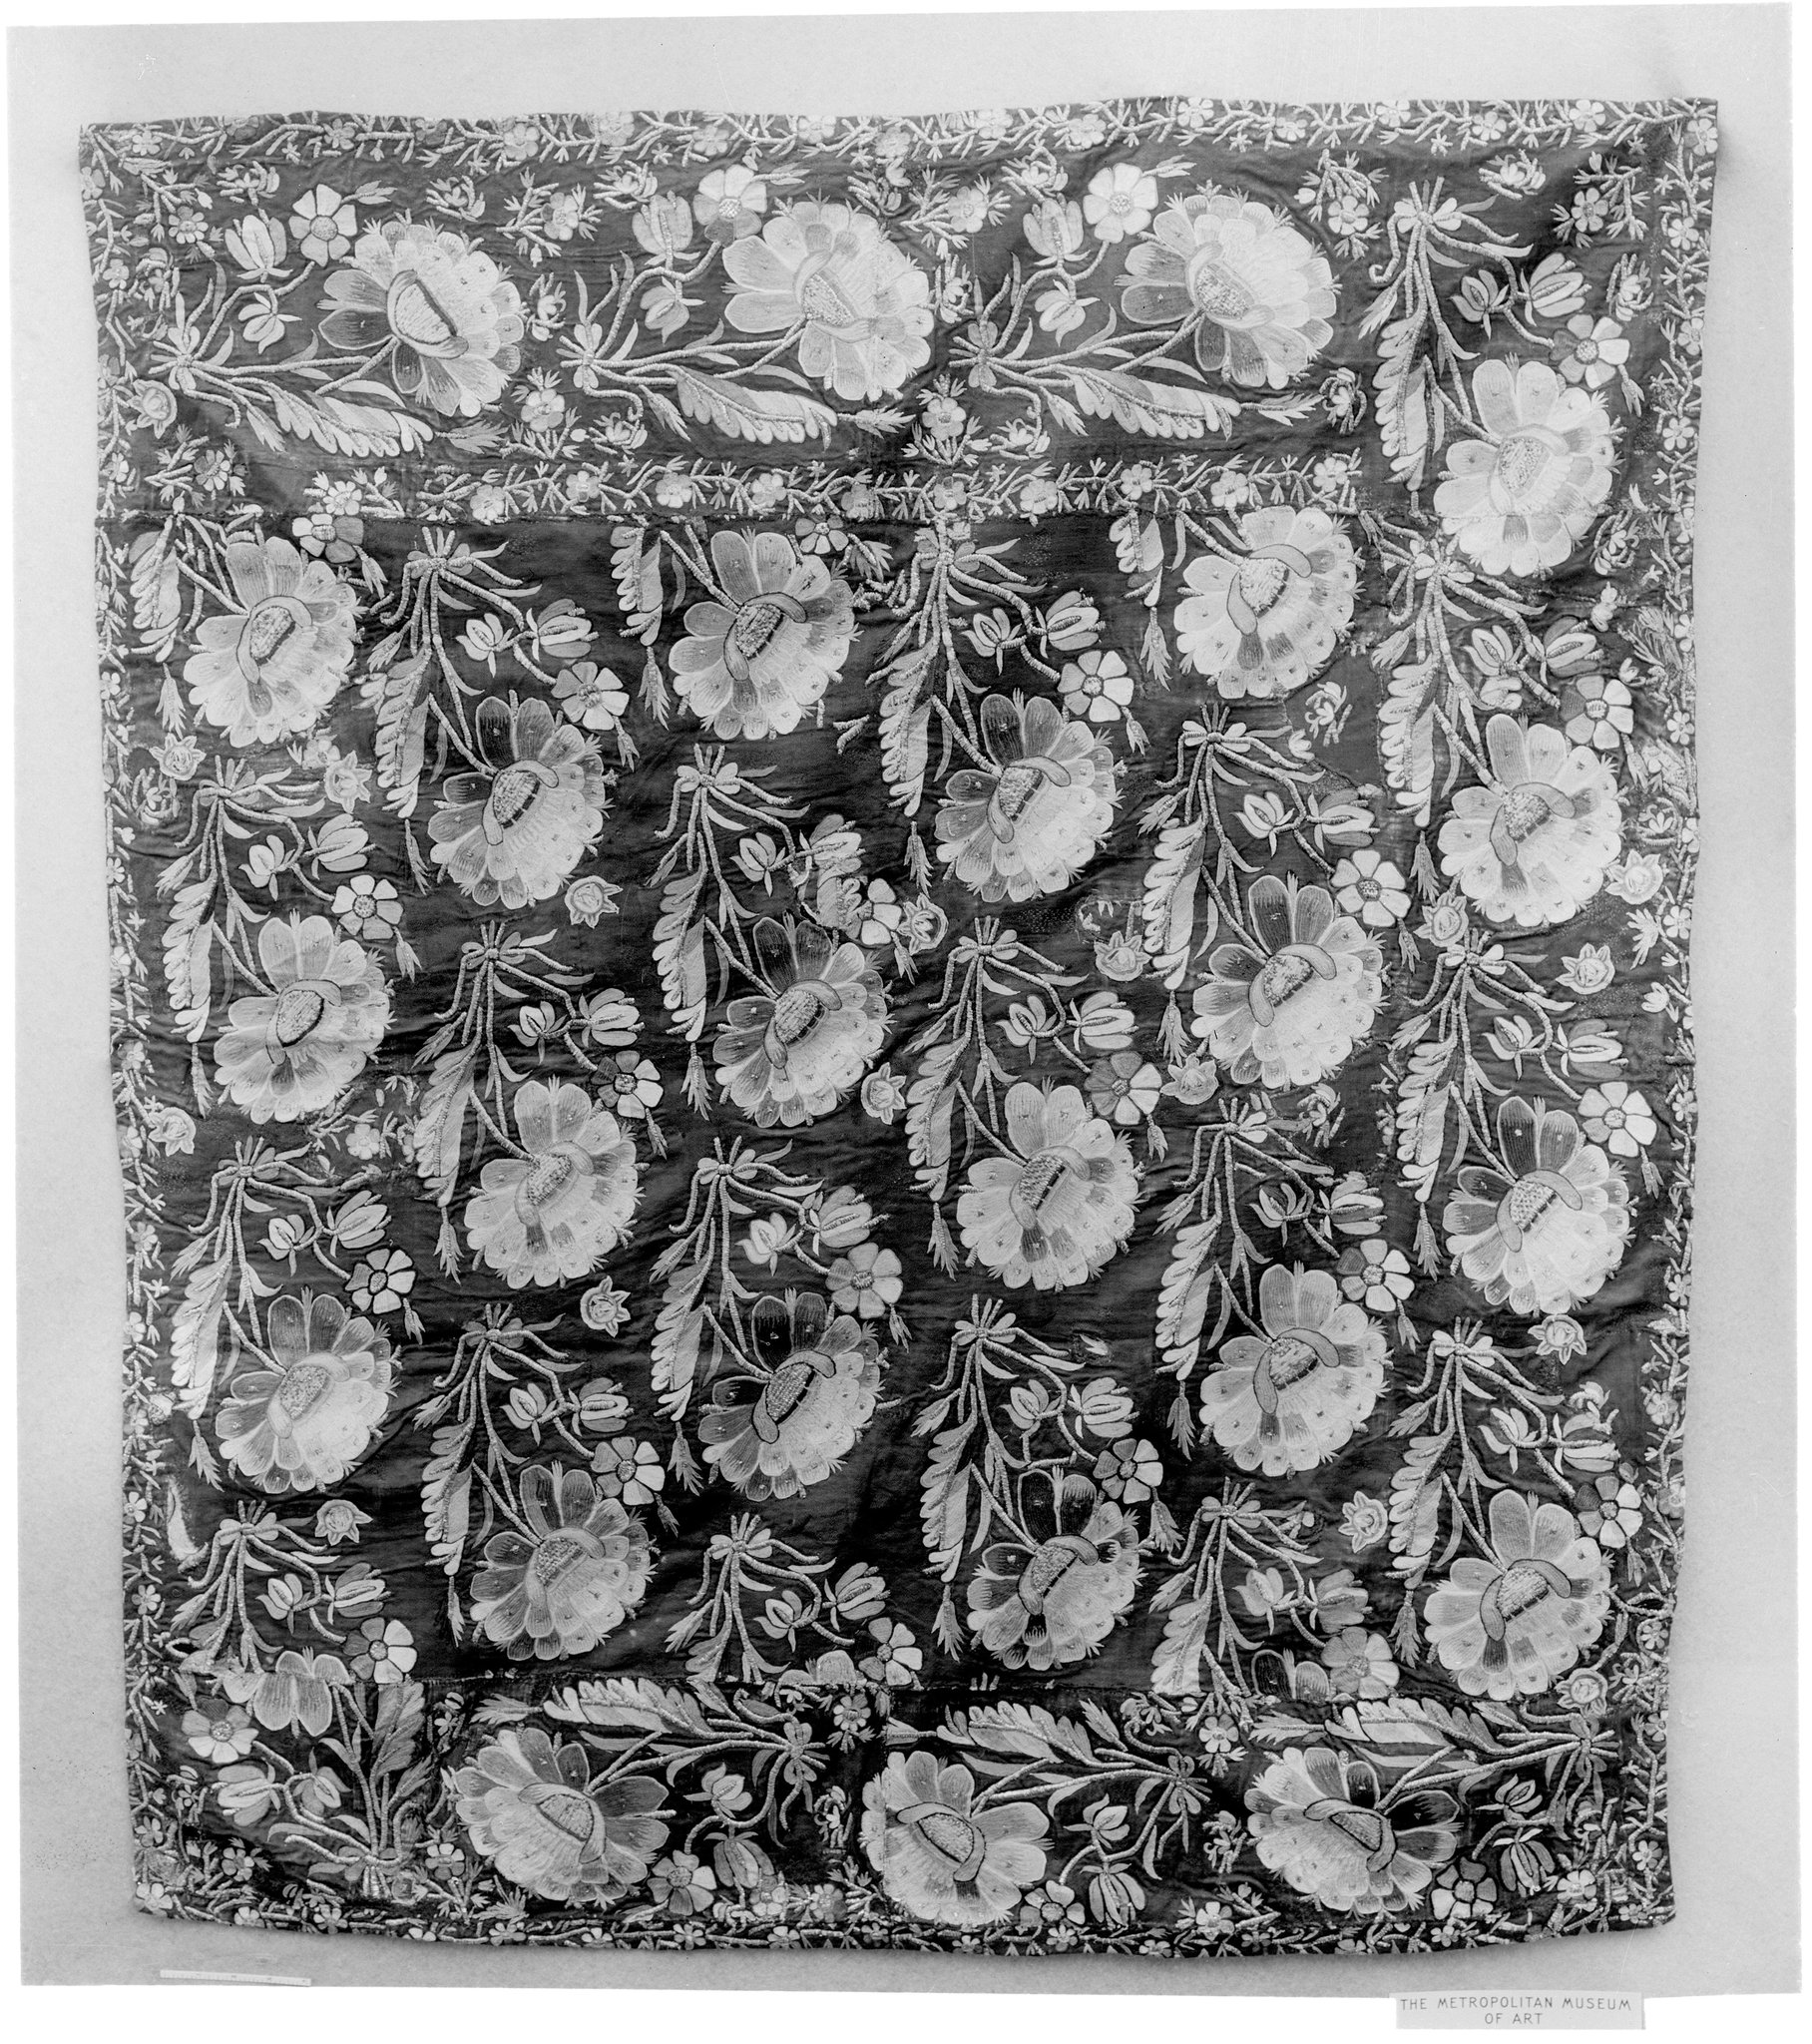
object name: cover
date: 1701-1833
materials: metal thread, silk, wool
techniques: embroidery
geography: turkey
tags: flowers